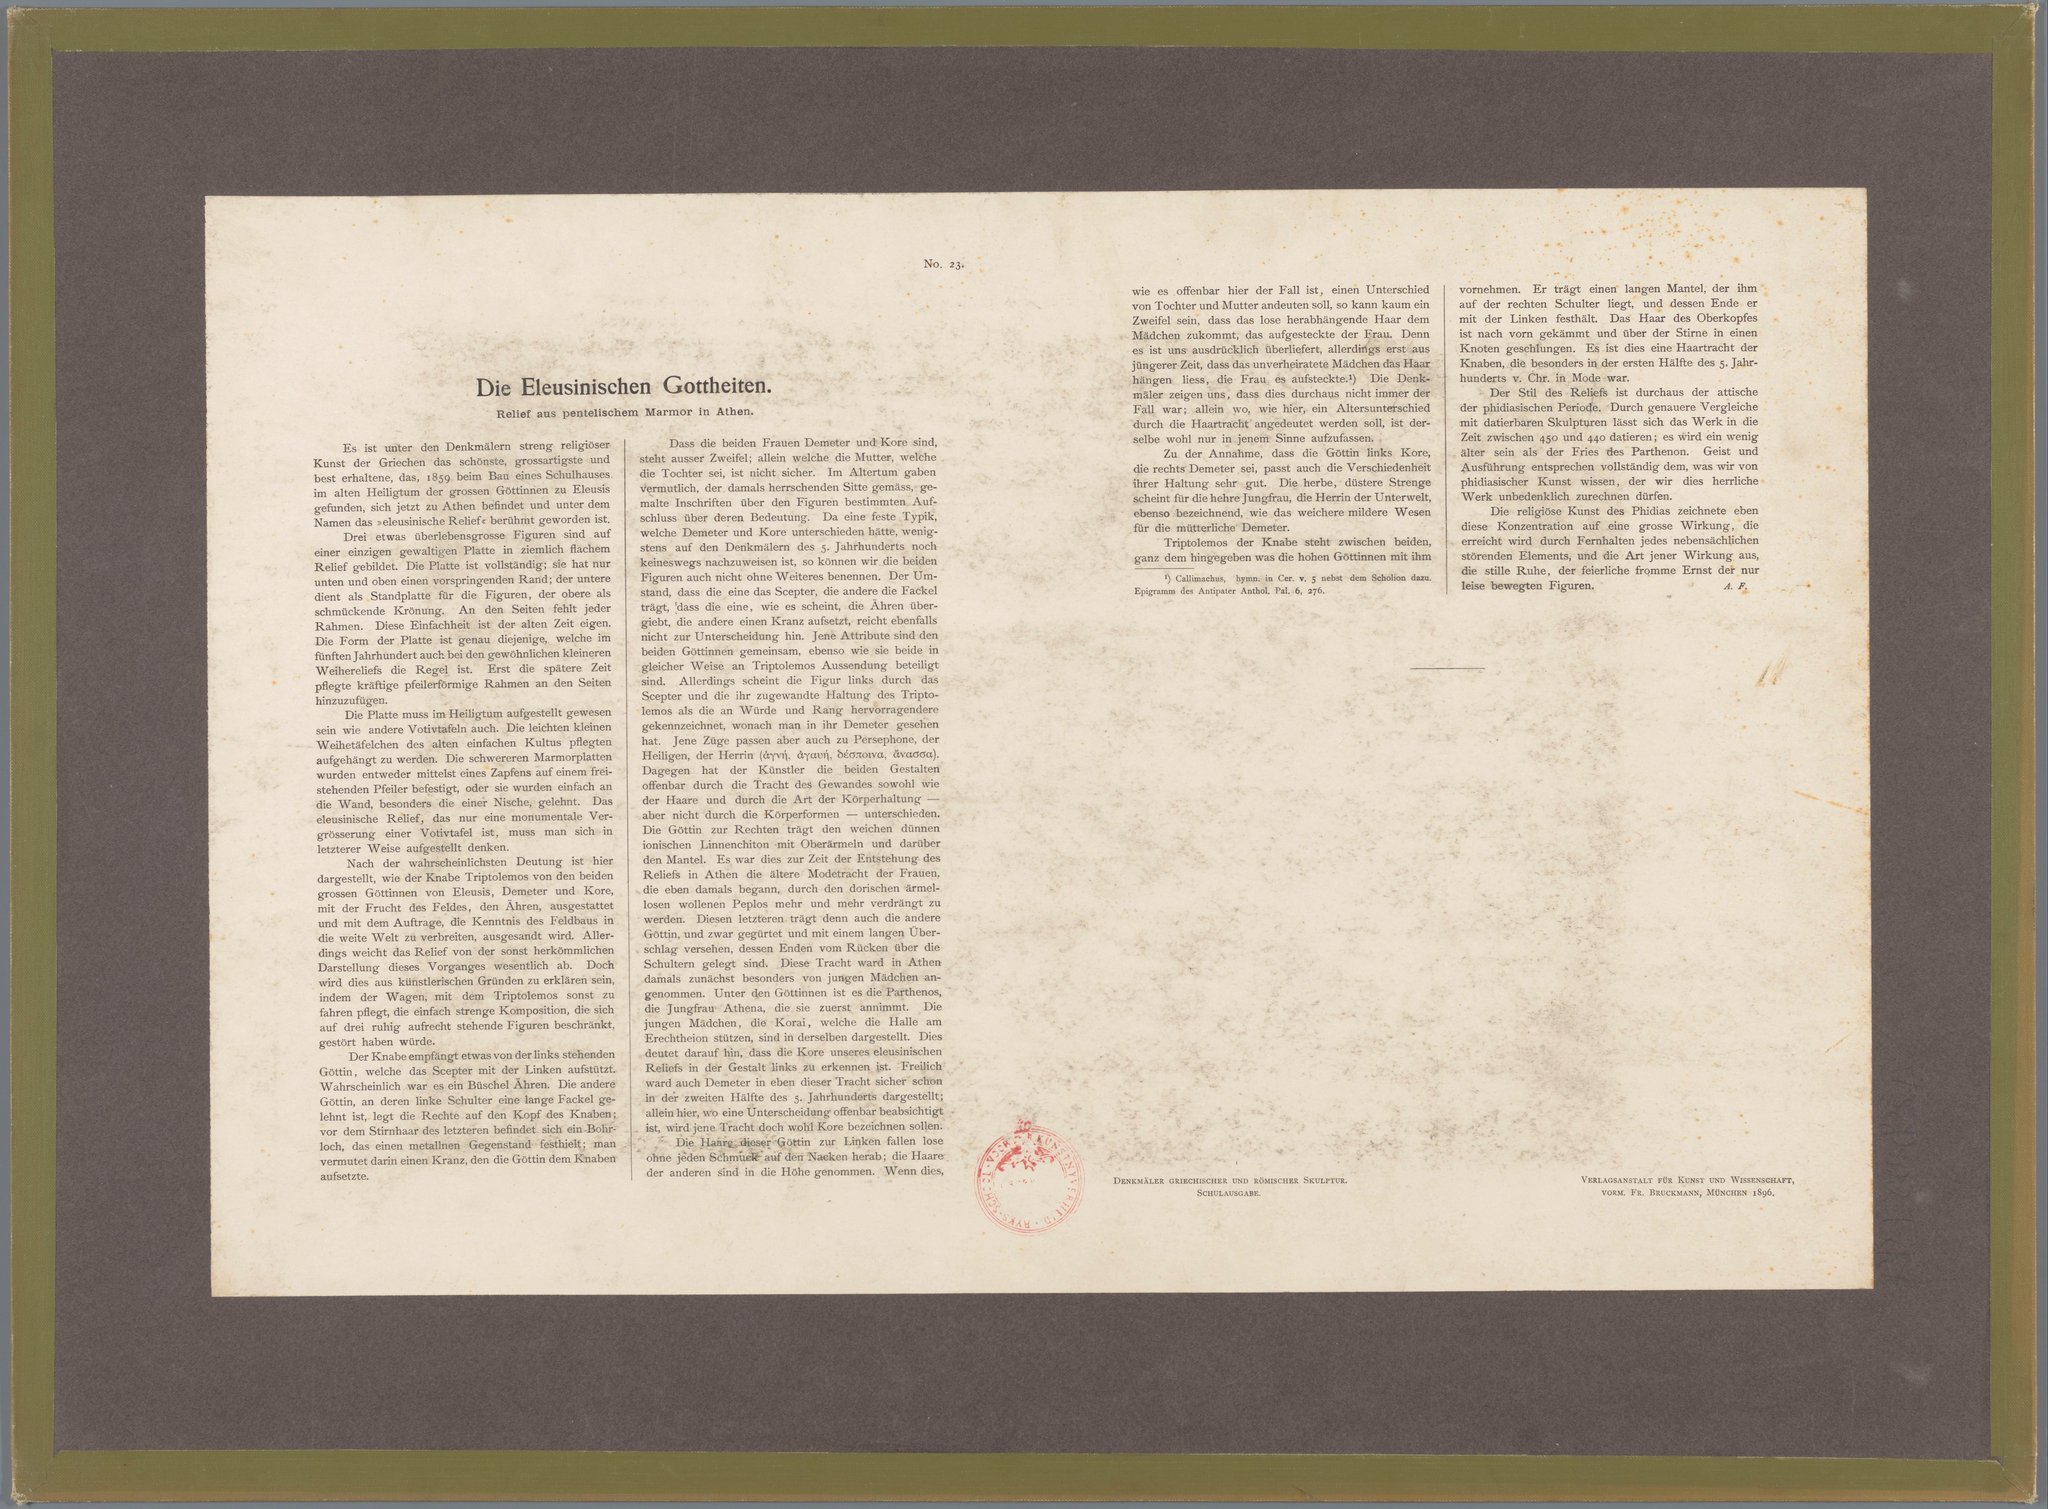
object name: photograph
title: Reliëf met Triptolemos, Demeter en Persephone in het Archeologisch Museum te Athene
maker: Anonymous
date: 1896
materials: cardboard, paper, ink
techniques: photograph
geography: national archaeological museum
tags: (story of) ceres (demeter), (story of) proserpina (persephone, core), libera, (story of) triptolemus, sculpture (+ relief ~ sculpture)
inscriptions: number: ‘No. 23.’, collector's mark: Lugt 3937, inscription: